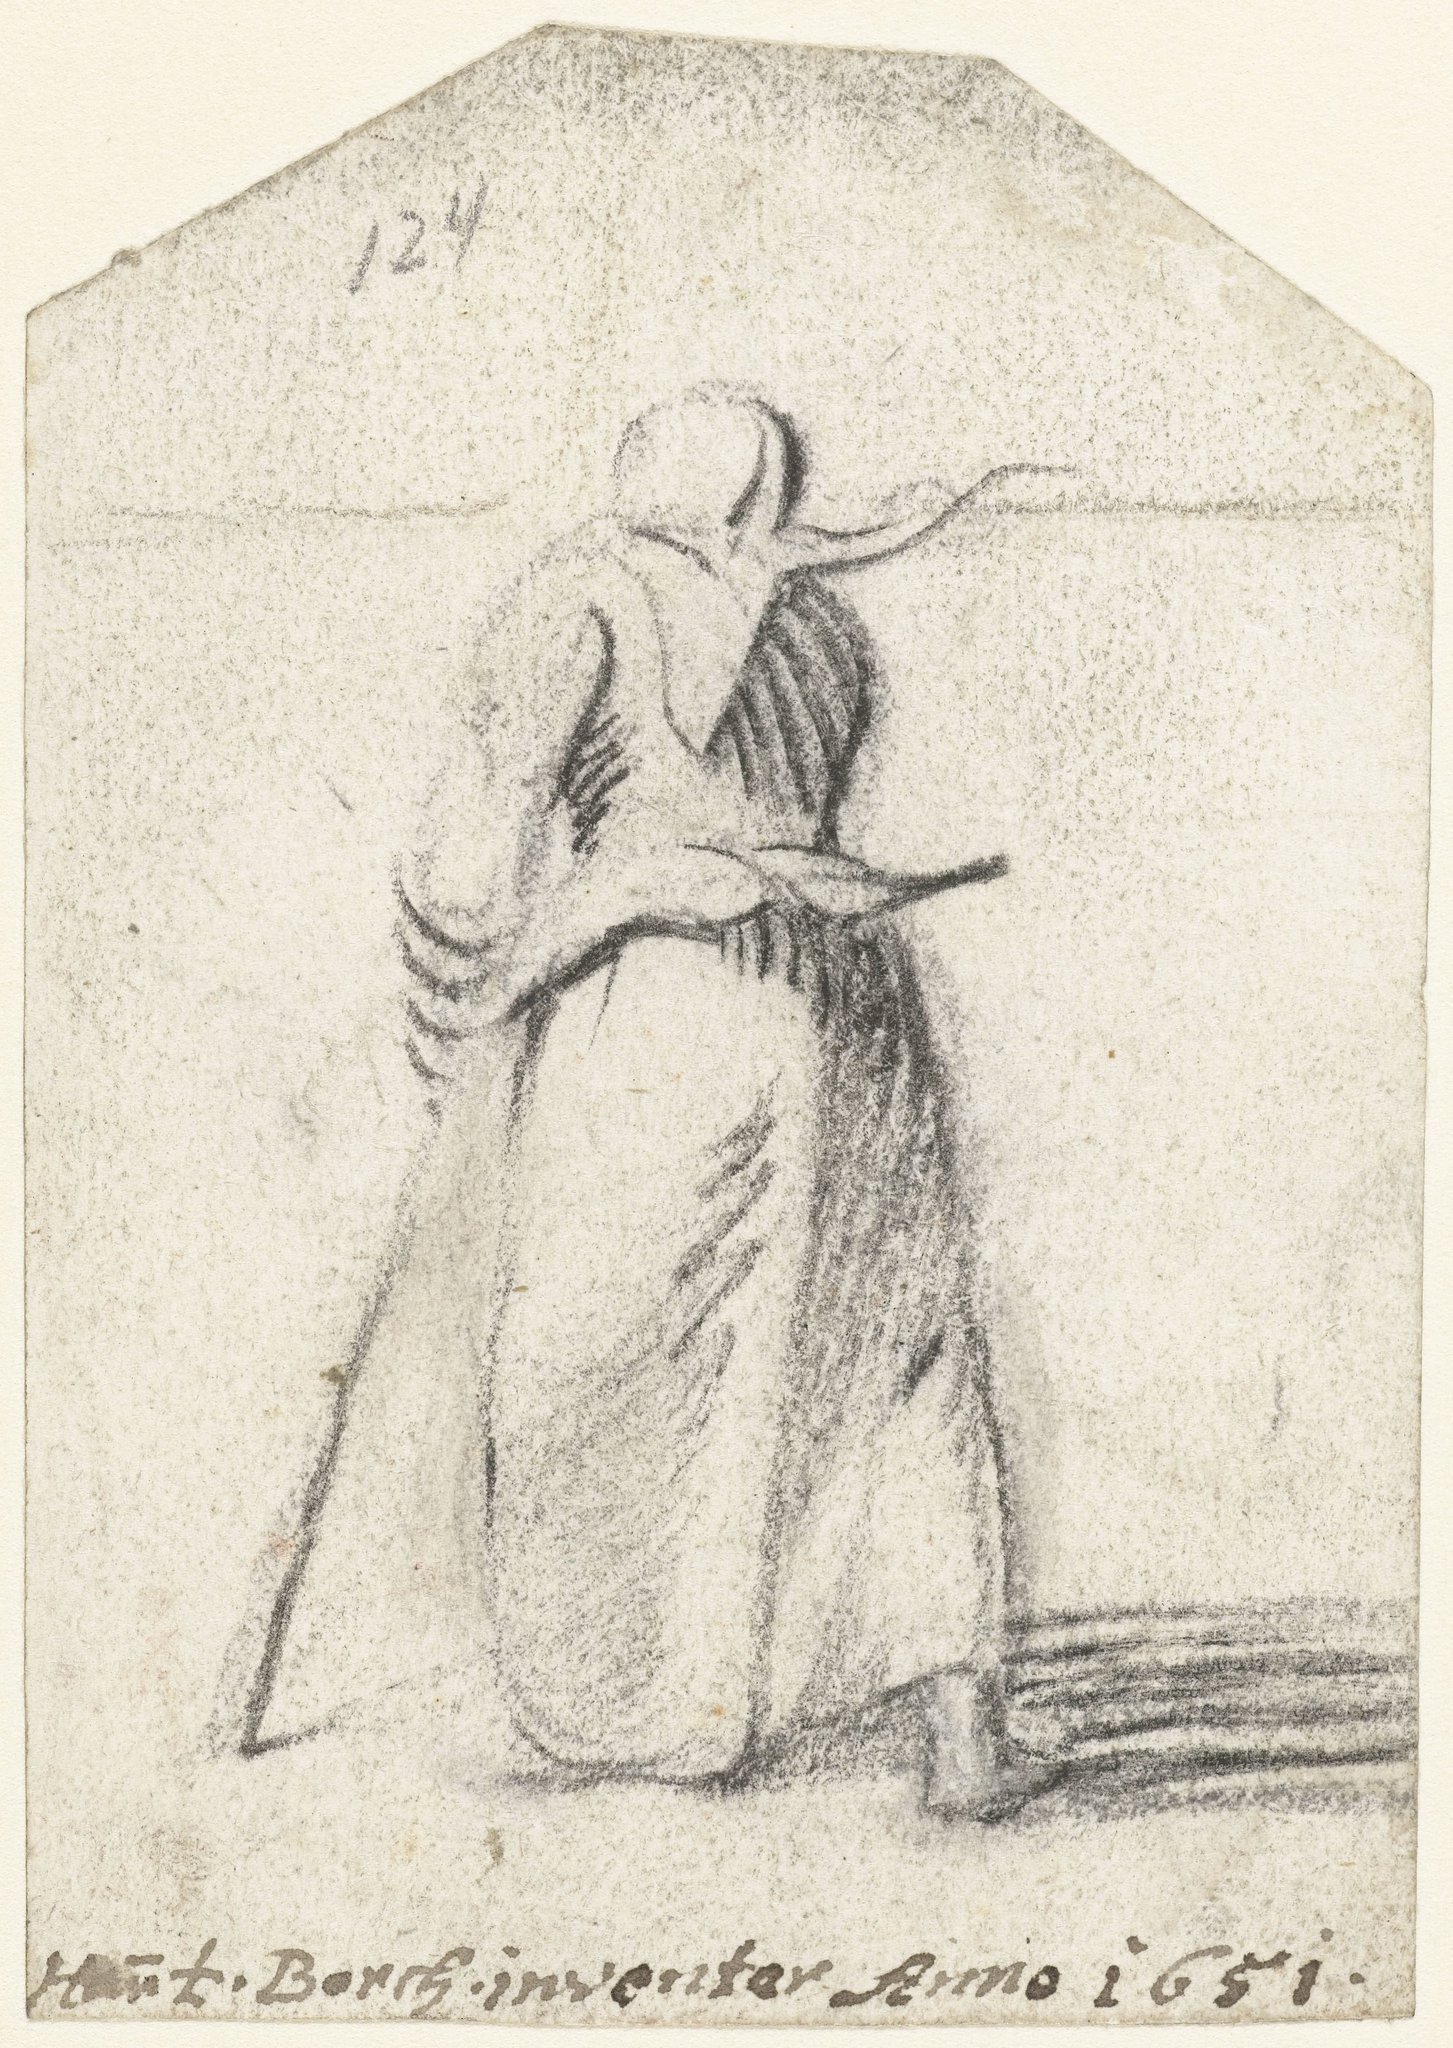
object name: drawing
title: Vrouw leunend op een stok, van achteren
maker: harmen ter borch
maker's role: draughtsman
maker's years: 1638-1677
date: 1651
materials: chalk, paper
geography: zwolle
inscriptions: annotation: ‘Har[men] t.Borch. inventor Anno 1651.’